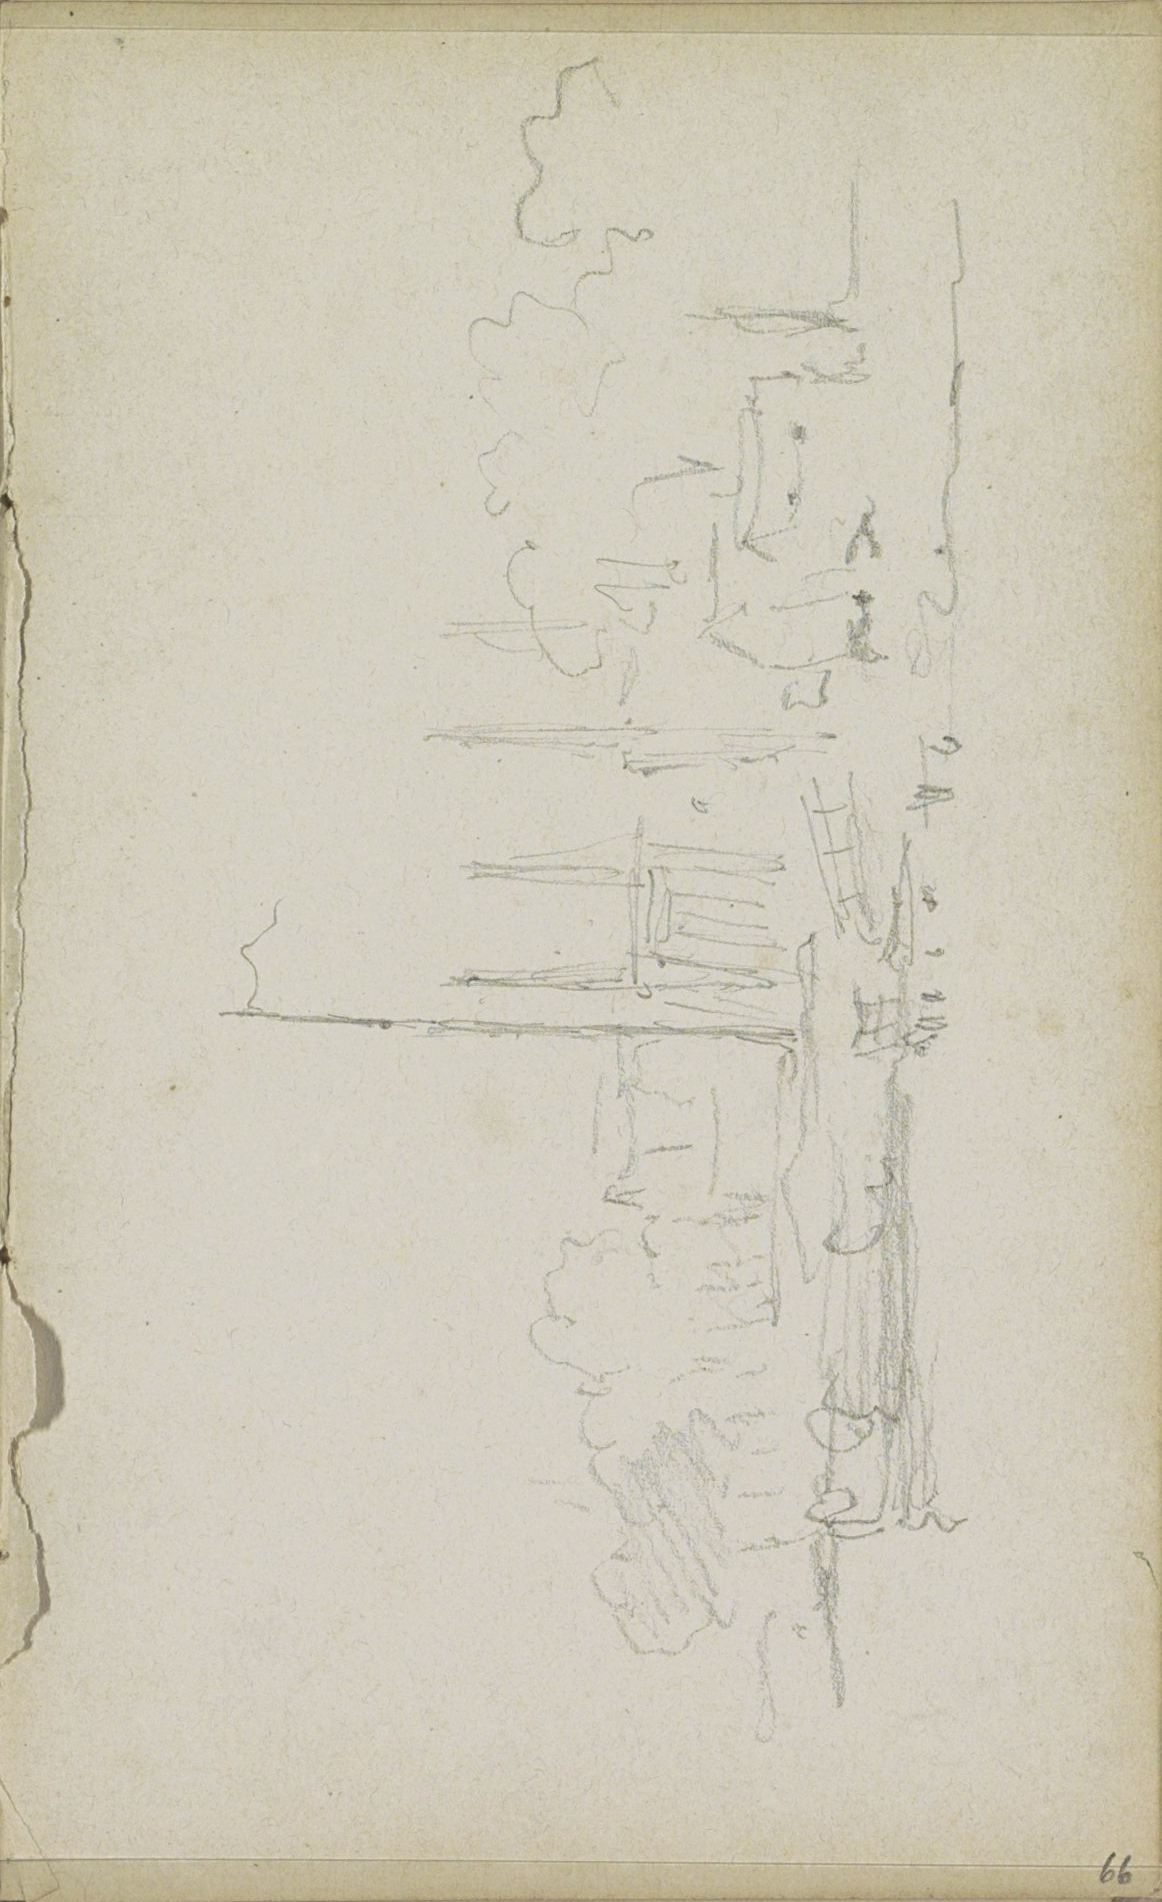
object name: sketchbook leaf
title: Gezicht op een brug over een kanaal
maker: adrianus eversen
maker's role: draughtsman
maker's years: 1818-1897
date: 1828-1897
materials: paper, pencil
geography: delft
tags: city-view, and landscape with man-made constructions, sailing-ship, sailing-boat, canal, delft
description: Gezicht op een brug over een kanaal, mogelijk in de omgeving van Delft. Links een zeilschip. Op de achtergrond bomen en gebouwen. Blad 66 recto uit een schetsboek met 69 bladen vervaardigd in de omgeving van Delft, Rotterdam, Oudewater en Harlingen.